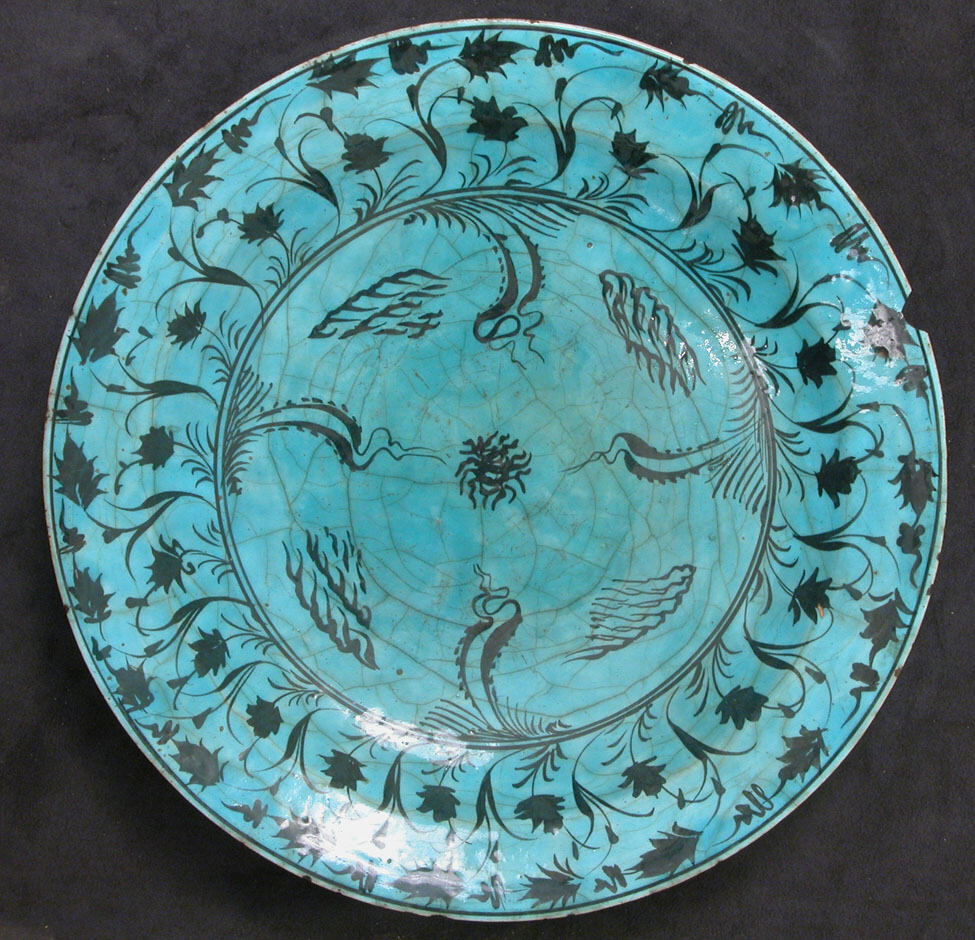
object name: plate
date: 1501-1700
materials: glaze, stonepaste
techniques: painting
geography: iran